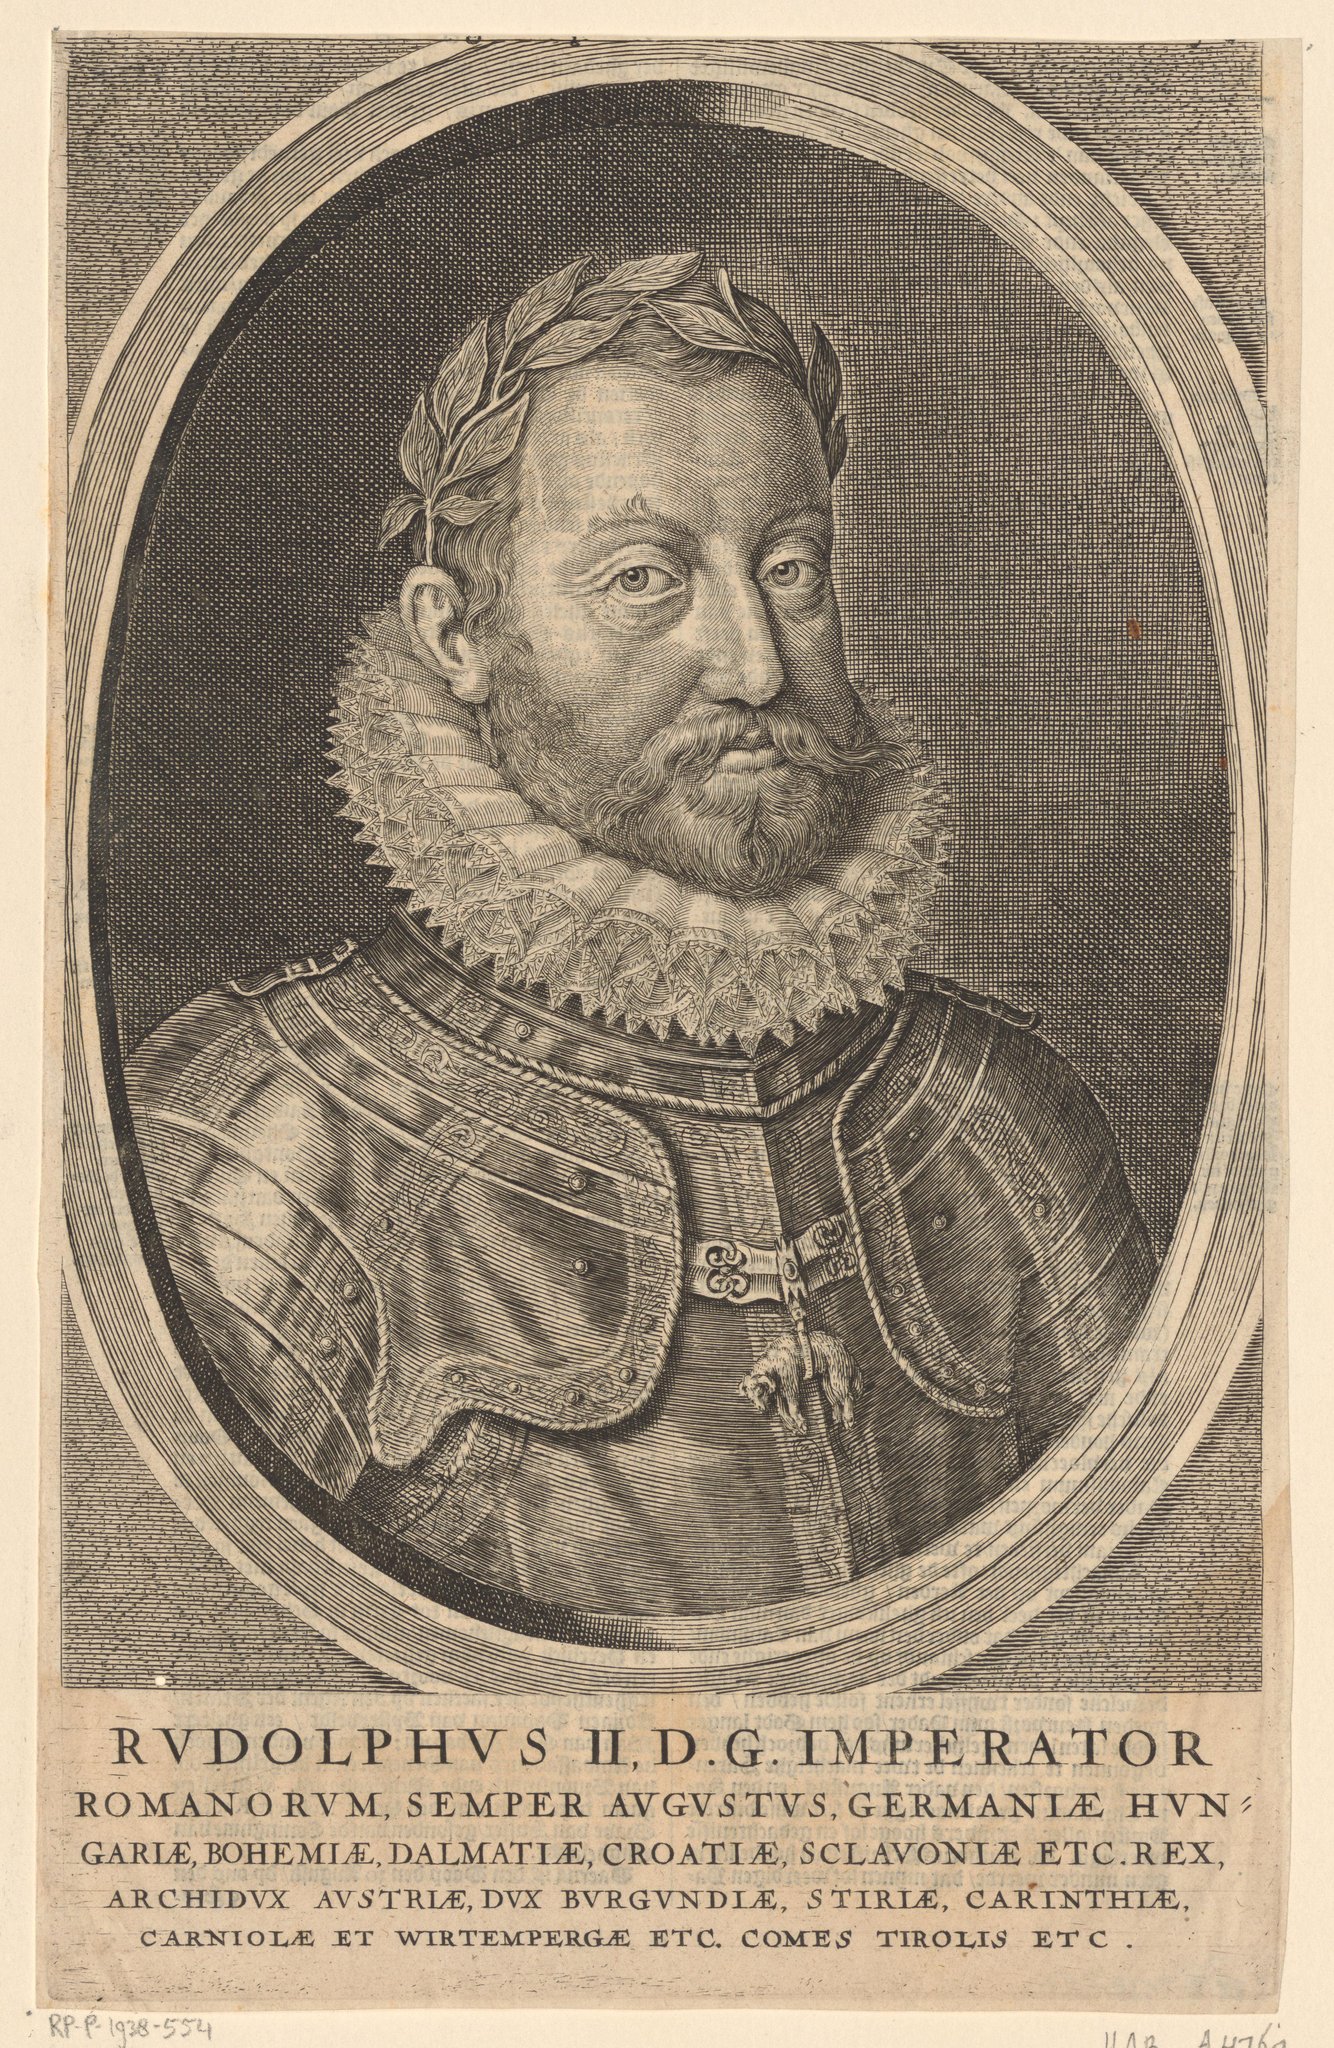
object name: print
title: Portret van Rudolf II van Habsburg, Duits keizer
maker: Anonymous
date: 1647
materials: paper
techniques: engraving, letterpress printing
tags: vienna, prague, rudolf ii van habsburg (duits keizer), armour, historical persons, knighthood order of the golden fleece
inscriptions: collector's mark: Lugt 2228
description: Prent uit: Meteren, Emanuel van. Historien der Nederlanden, en haar naburen oorlogen (...). Zaandam: Hendrik Jacobsz Soeteboom, 1647, p. 335.